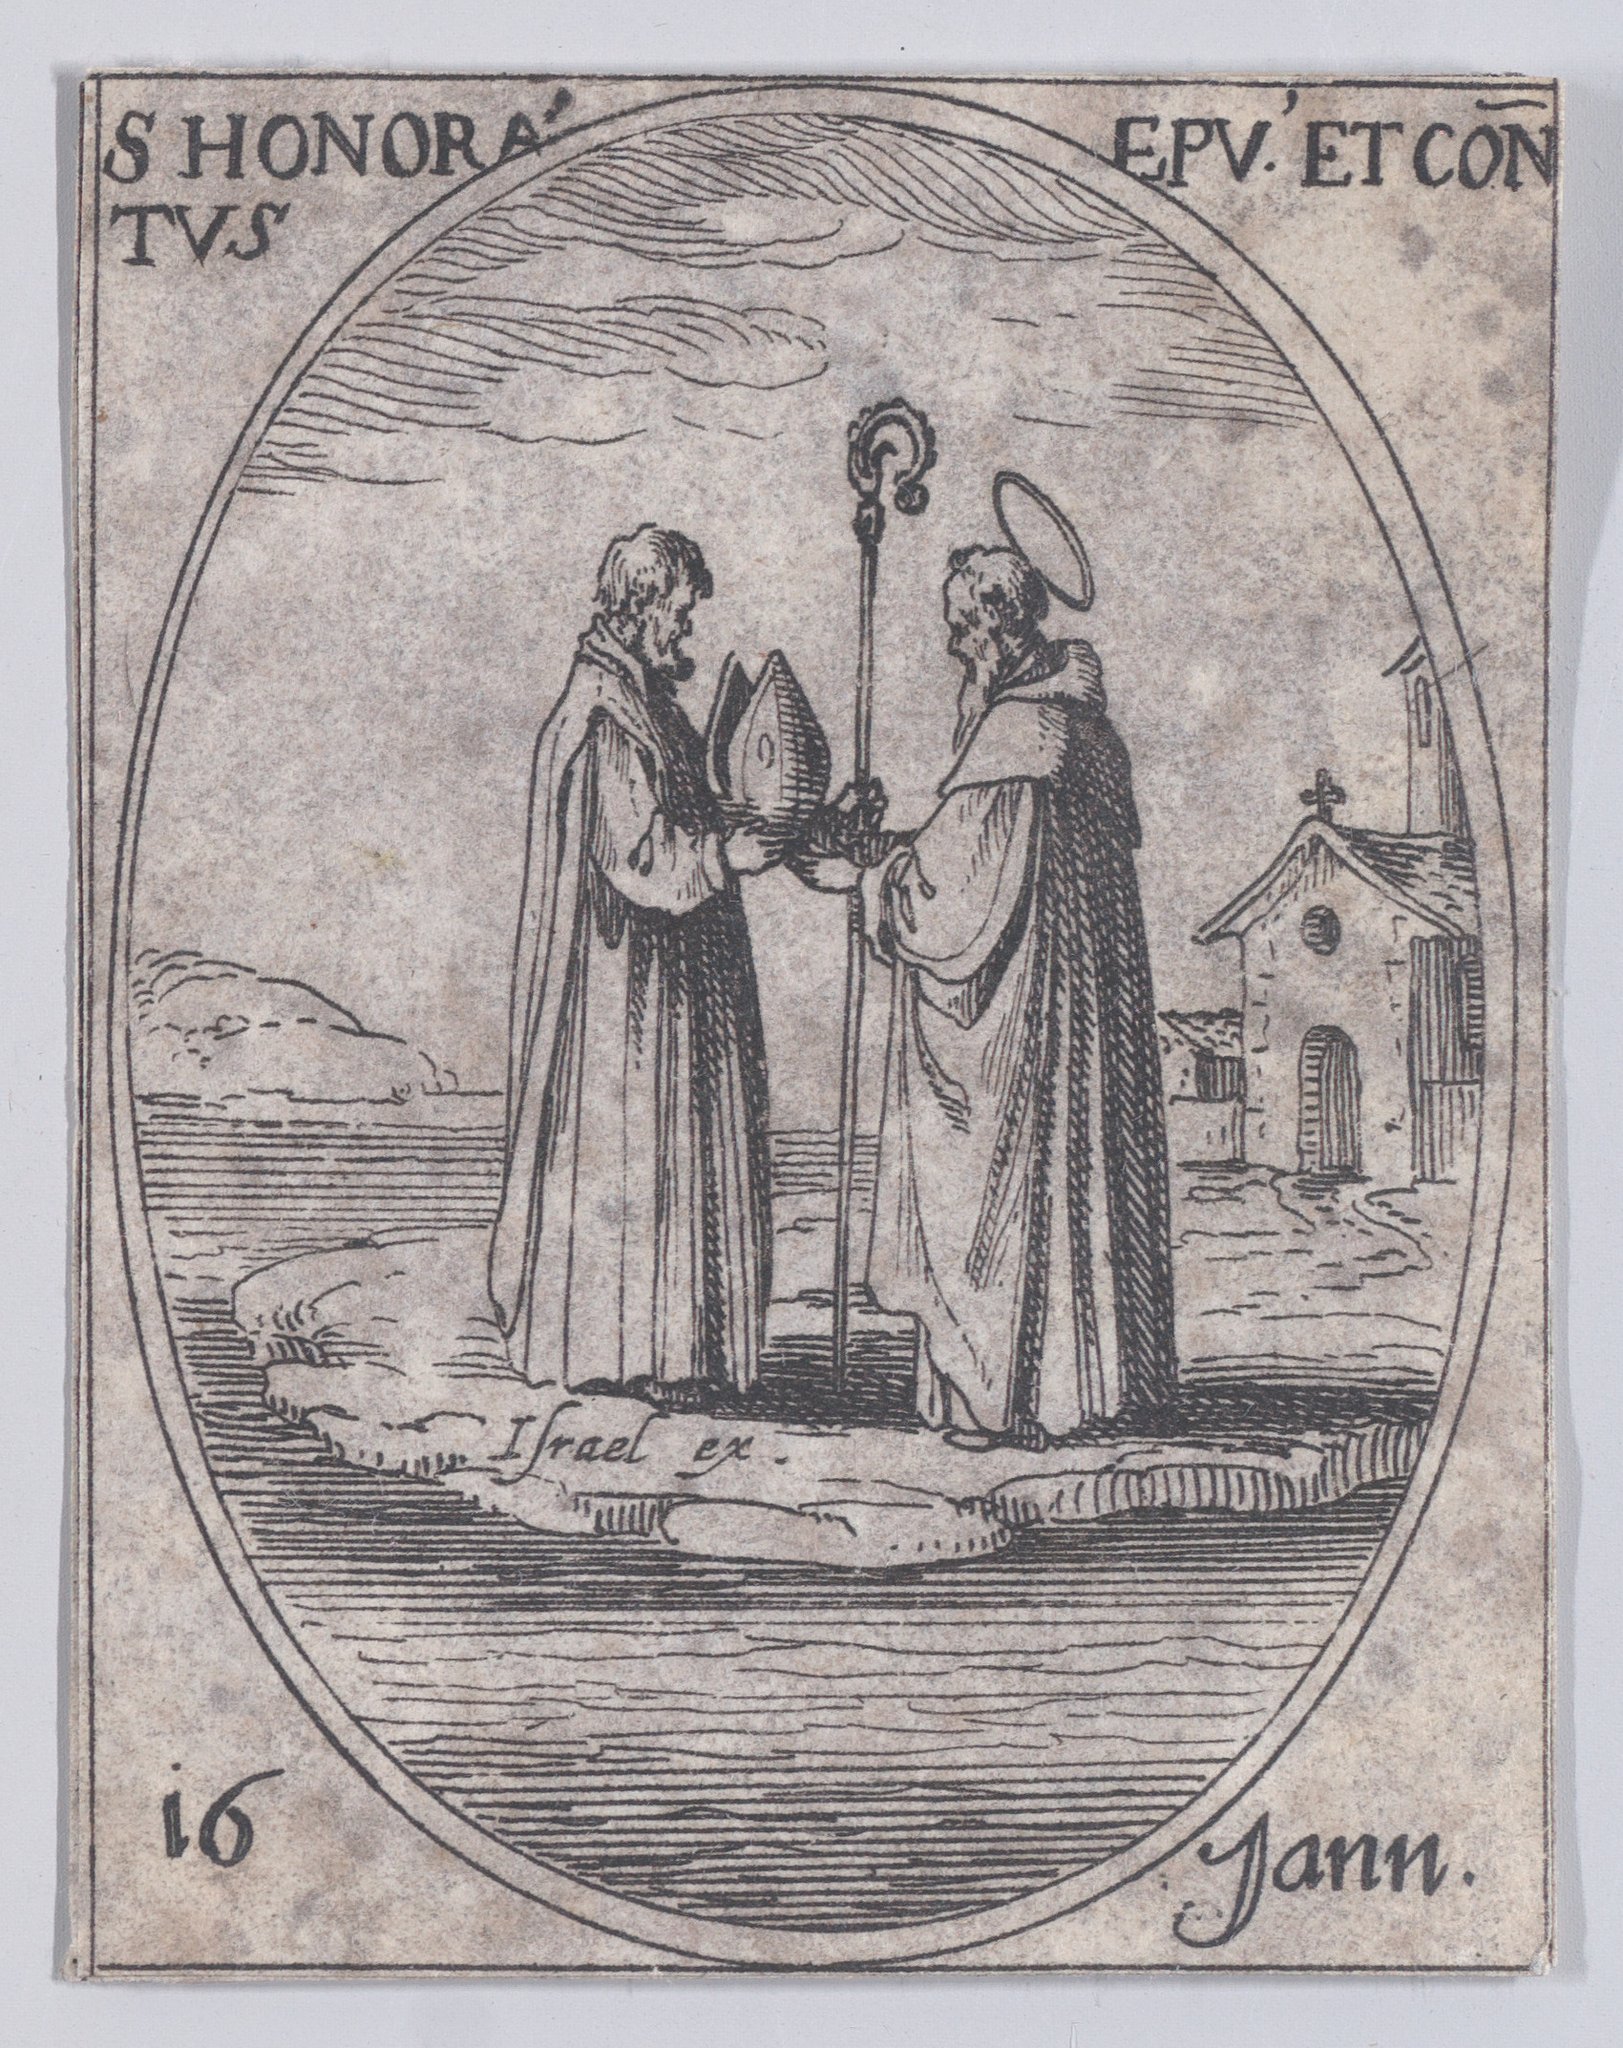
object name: print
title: S. Honorat, évêque et confesseur (St. Honoratus, Bishop and Confessor), January 16th, from "Les Images De Tous Les Saincts et Saintes de L'Année" (Images of All of the Saints and Feast Days of the Year)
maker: jacques callot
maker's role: artist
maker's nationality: french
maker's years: 1592-1635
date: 1636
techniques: etching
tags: men,saints